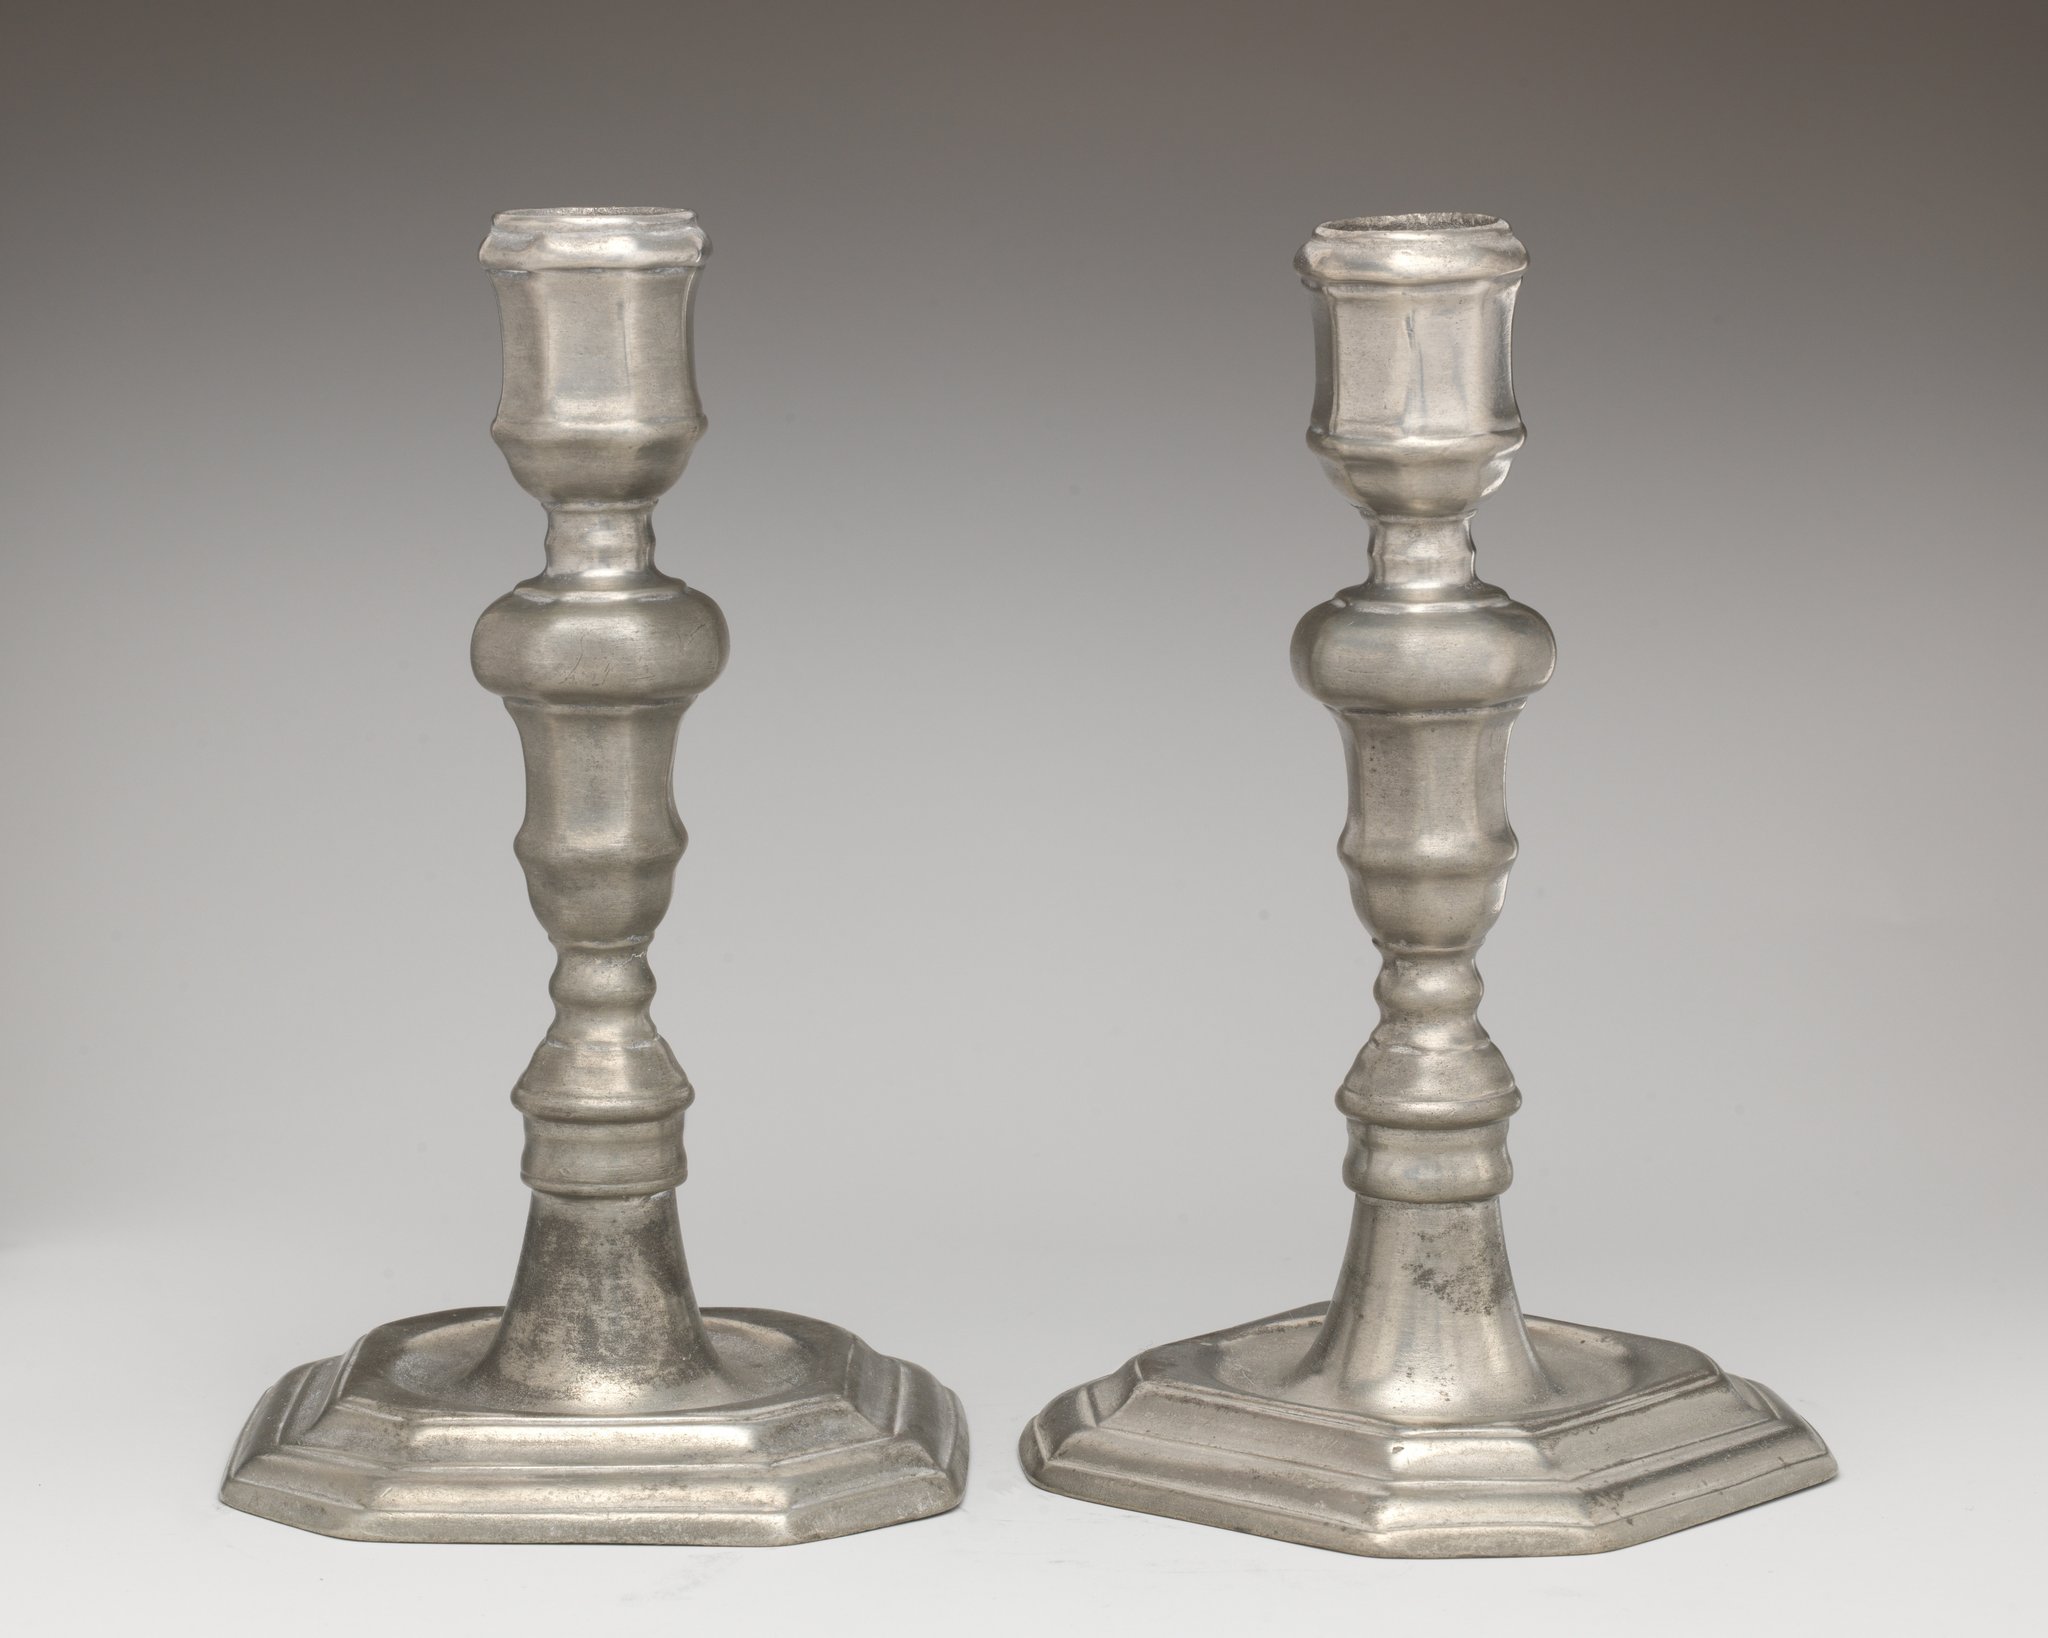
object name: candlestick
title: Pair of candlesticks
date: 1701-1733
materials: pewter